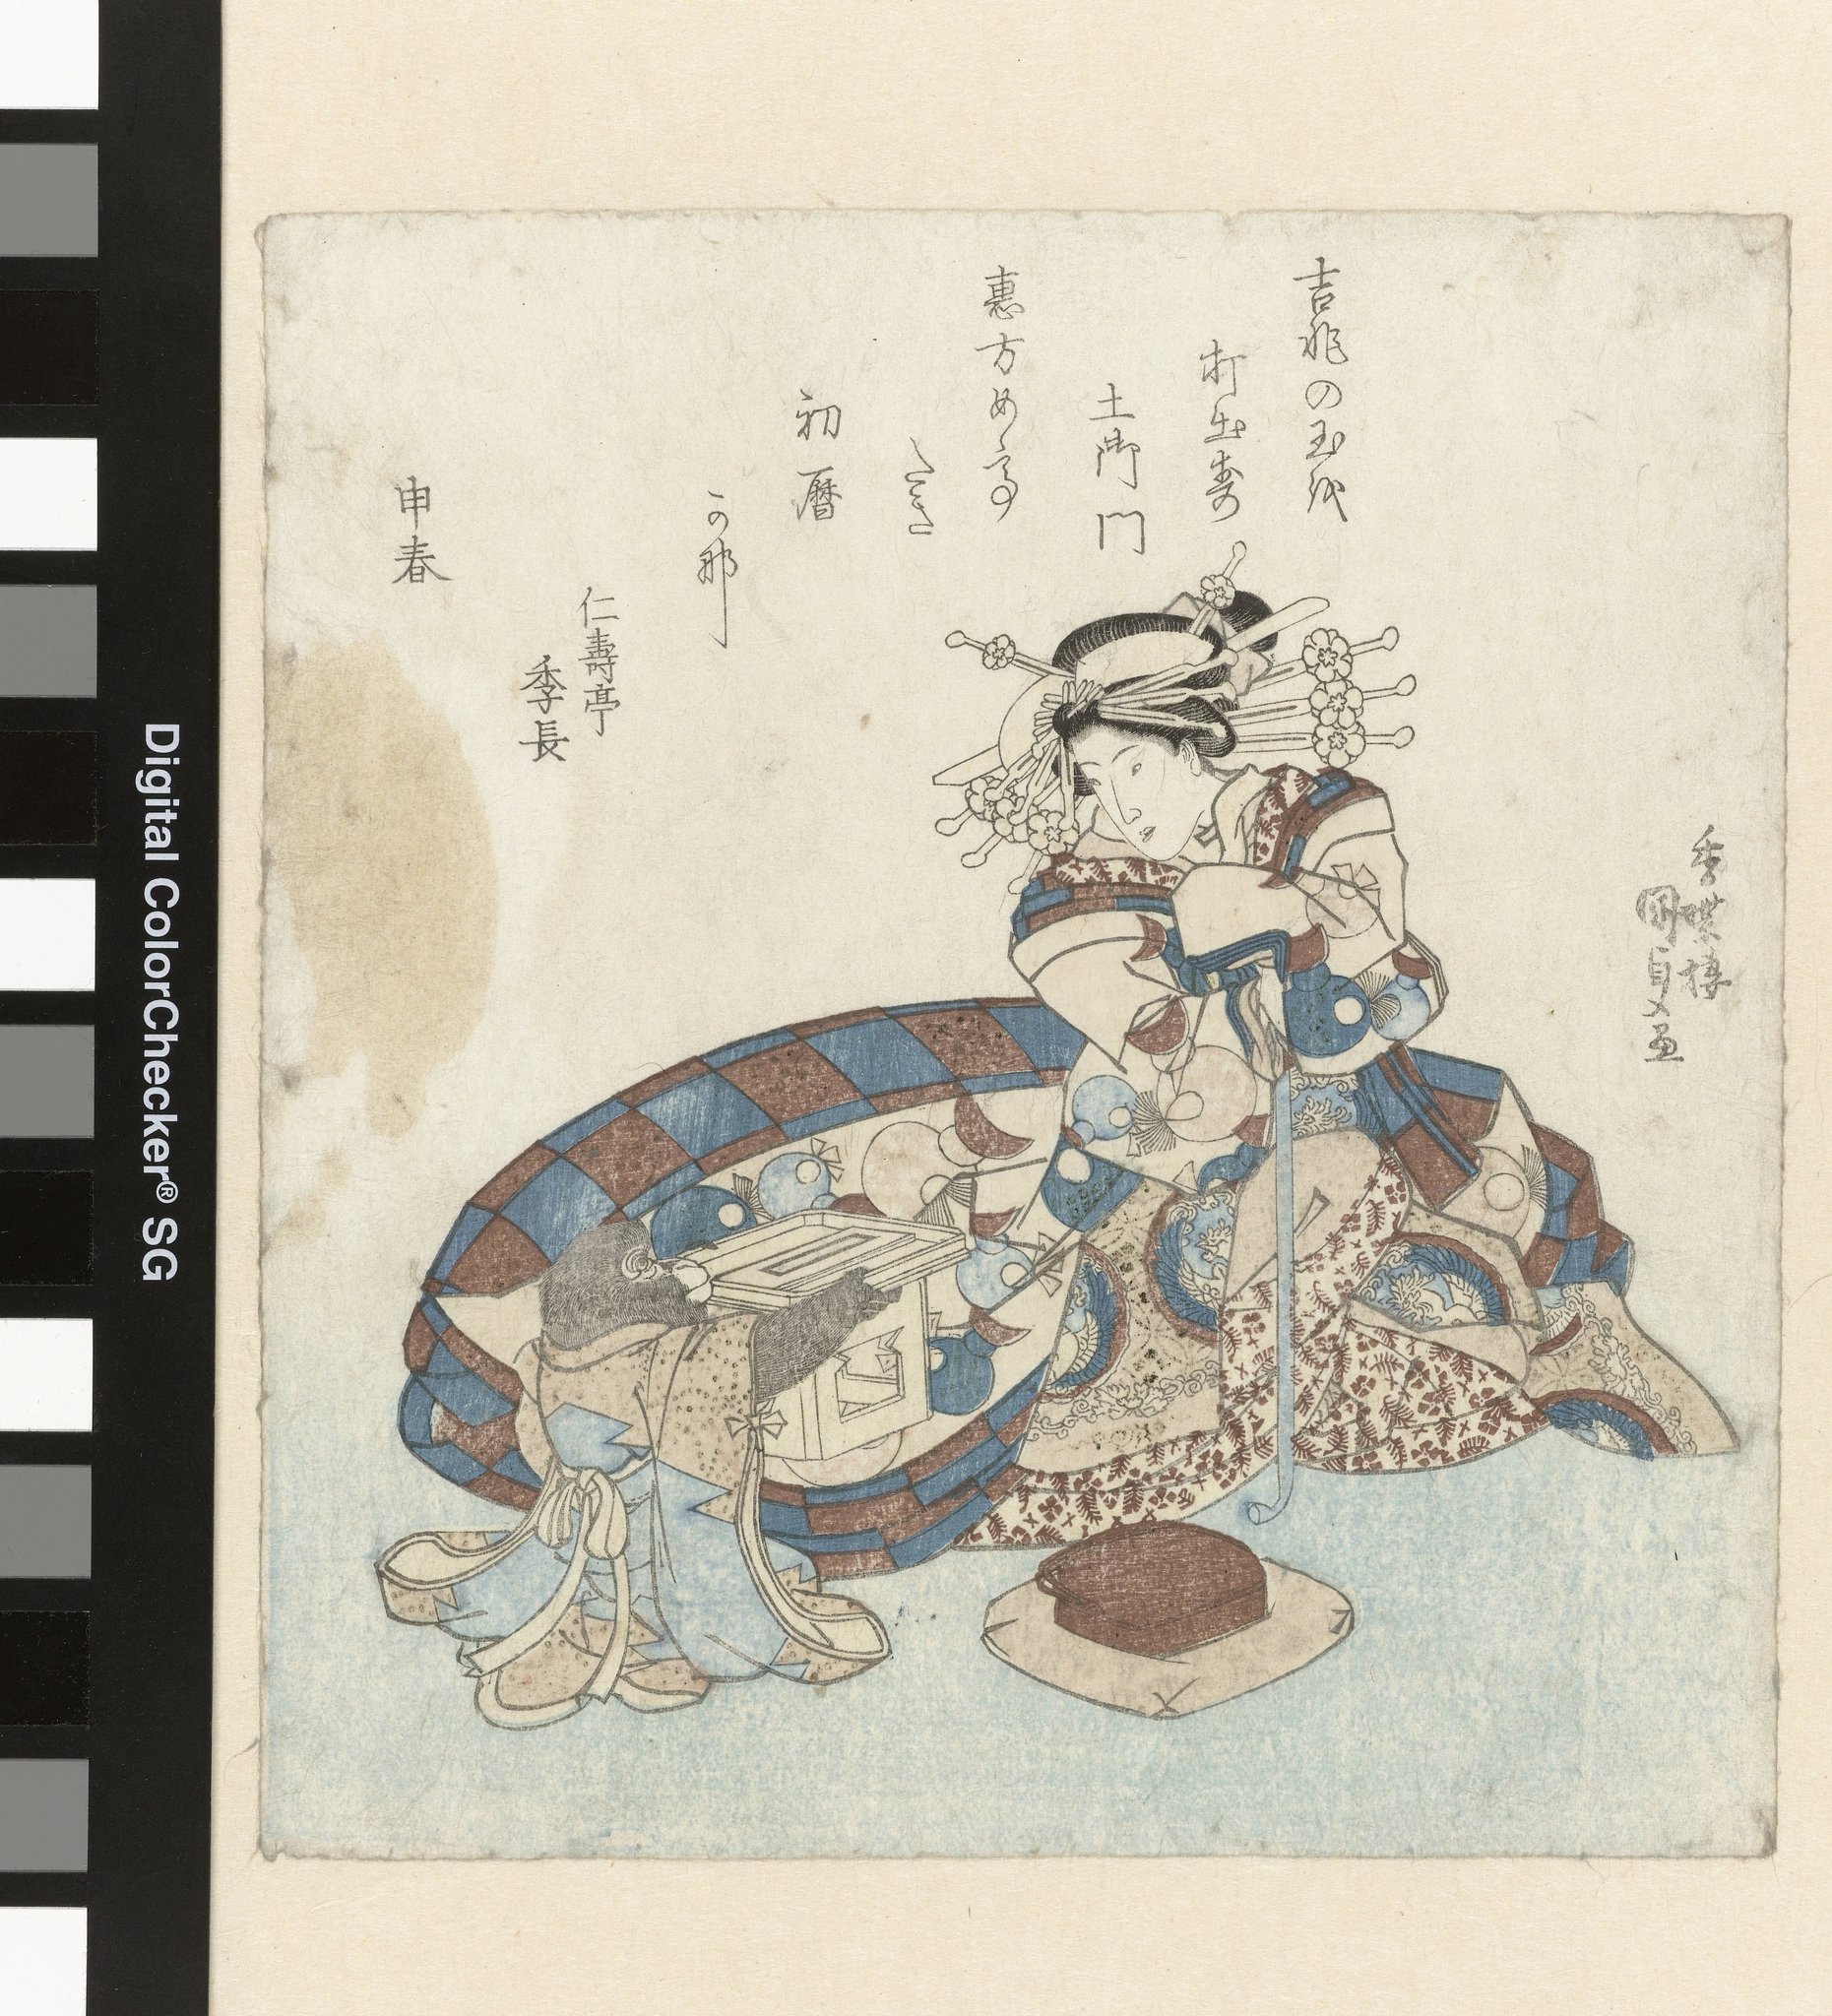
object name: print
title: Aapje biedt een almanak aan een courtisane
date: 1836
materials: paper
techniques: woodcut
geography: japan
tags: monkeys, apes, courtesan, hetaera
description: Een surimono is een luxe uitgevoerde prent waarop beeld met één of meerdere gedichten gecombineerd is. Bij het drukken van een surimono werd vaak gebruik gemaakt van dikker papier, blinddruk en metaal pigmenten, zoals koper- en zilverpoeder. De prenten werden vaak in opdracht van dichters gemaakt en als exclusief geschenk aan vrienden en relaties gegeven.